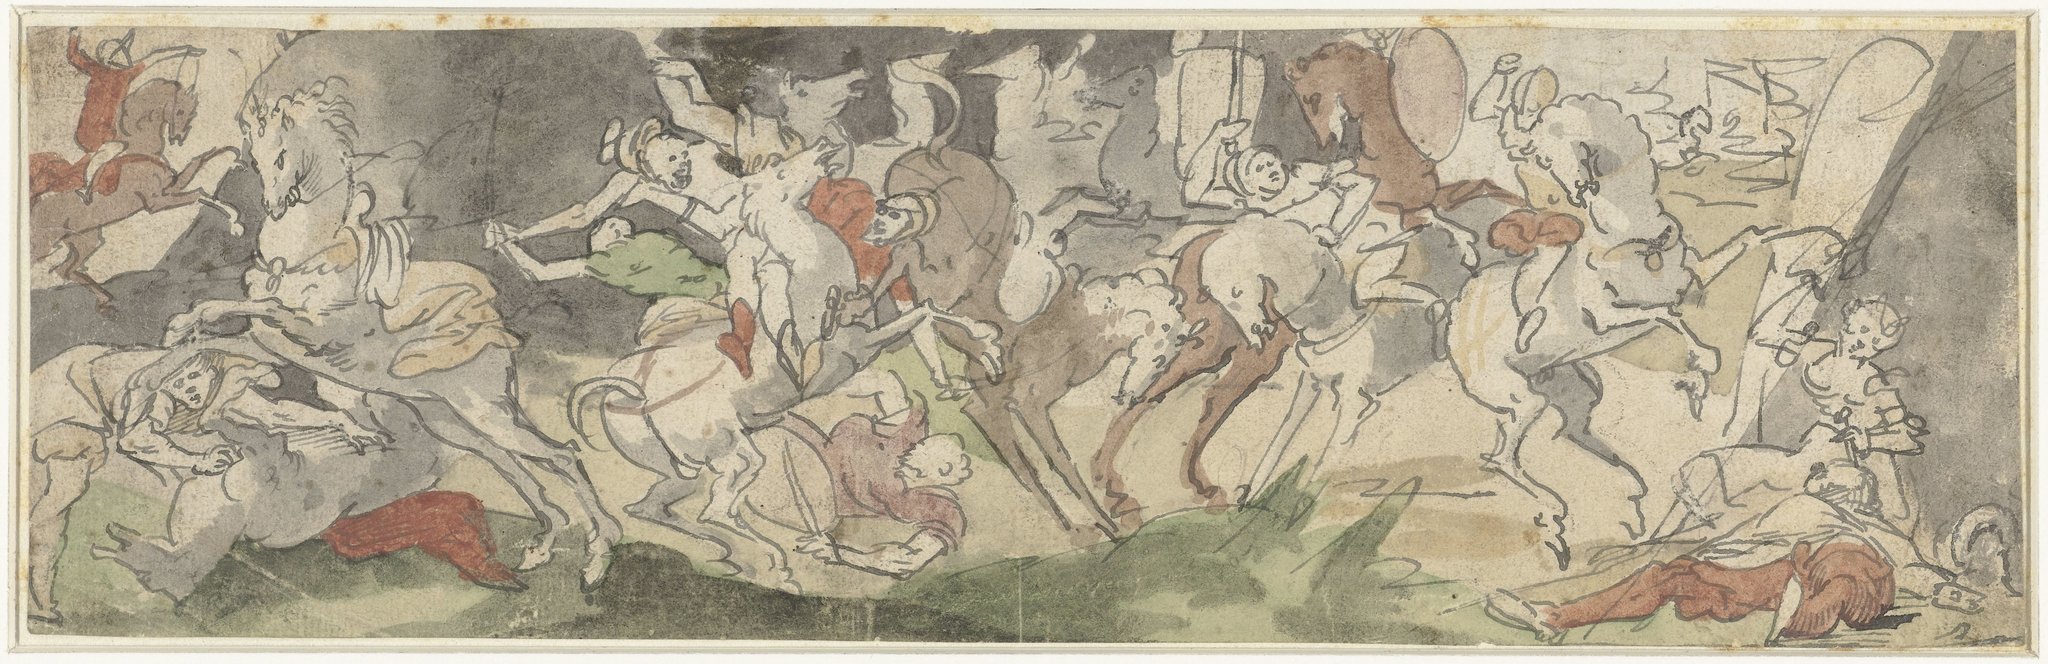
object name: drawing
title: Gevechtscène met ruiters, rechts Jael en Sisera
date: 1500-1600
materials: ink, paper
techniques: brush, pen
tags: story of jael and sisera